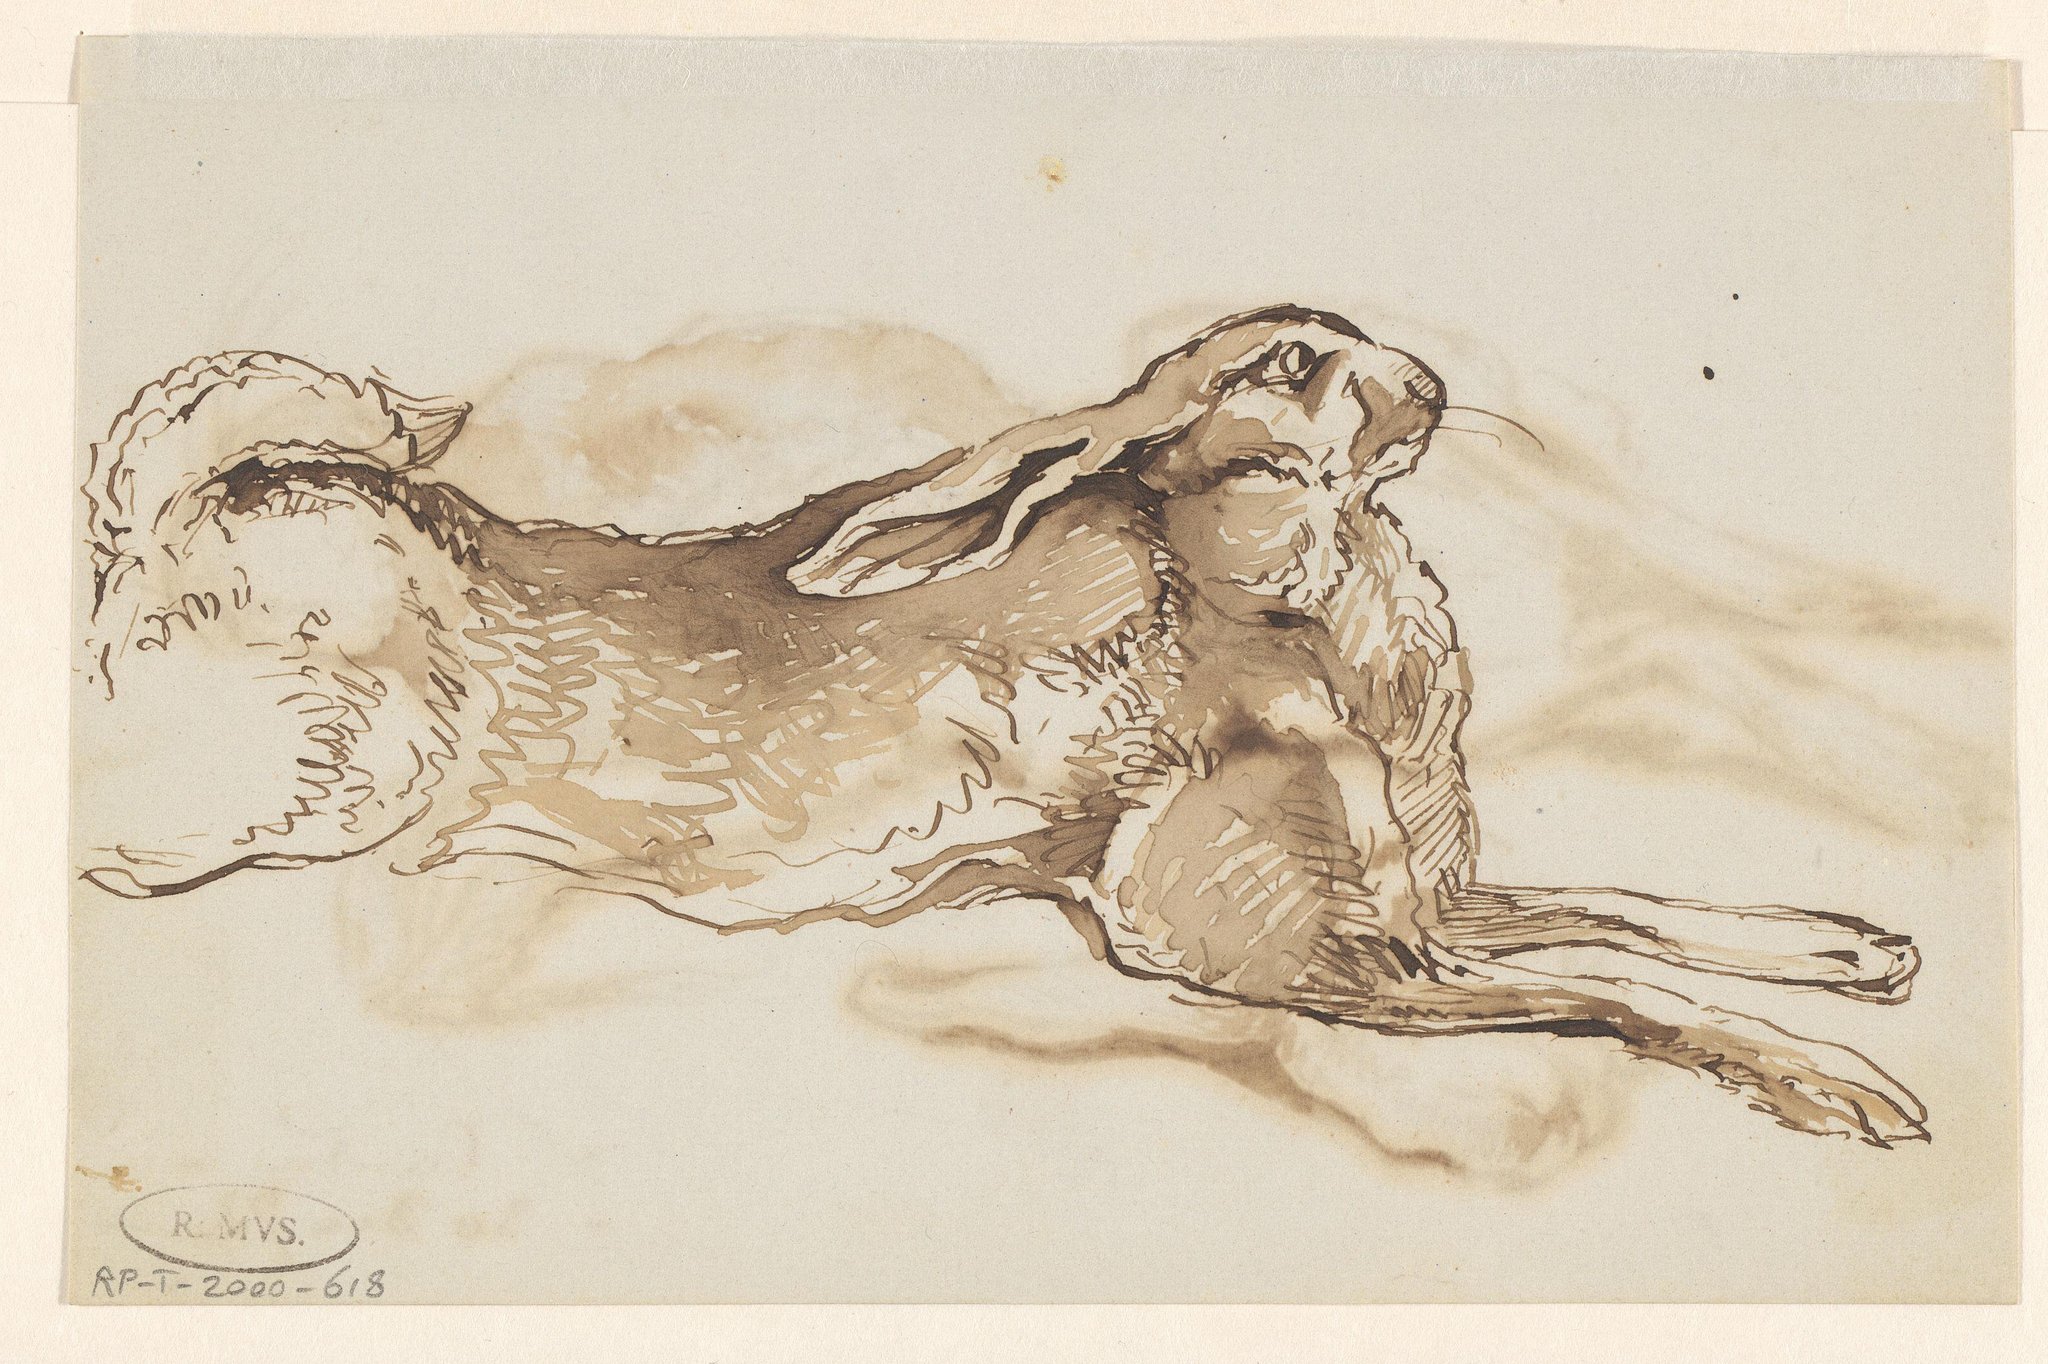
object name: drawing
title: Haas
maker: johannes tavenraat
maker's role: draughtsman, painter, print maker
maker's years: 1809-1881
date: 1872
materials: ink, paper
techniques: brush, pen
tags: rodents: hare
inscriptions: date: ‘Canta - 30 Dec 72 -’, collector's mark: Lugt 2228